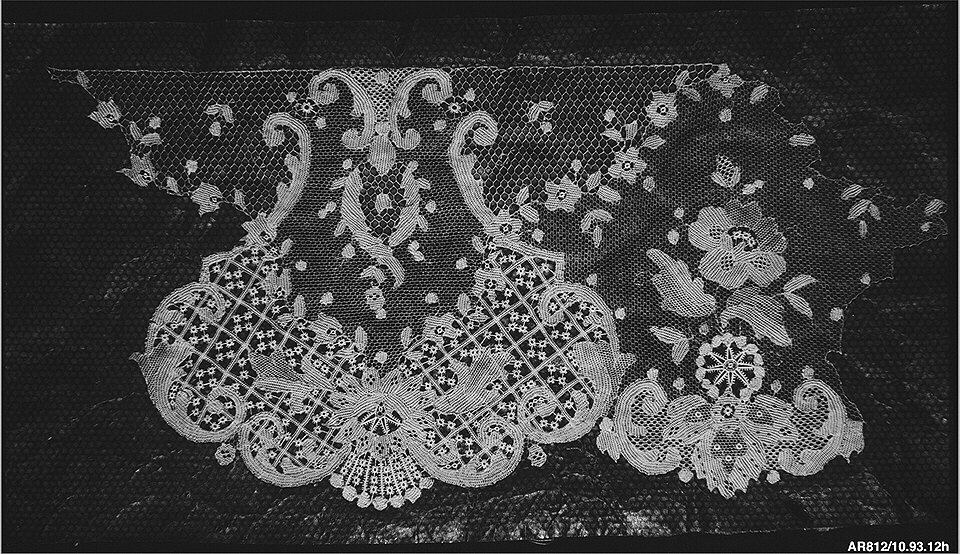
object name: sample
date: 1801-1900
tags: flowers